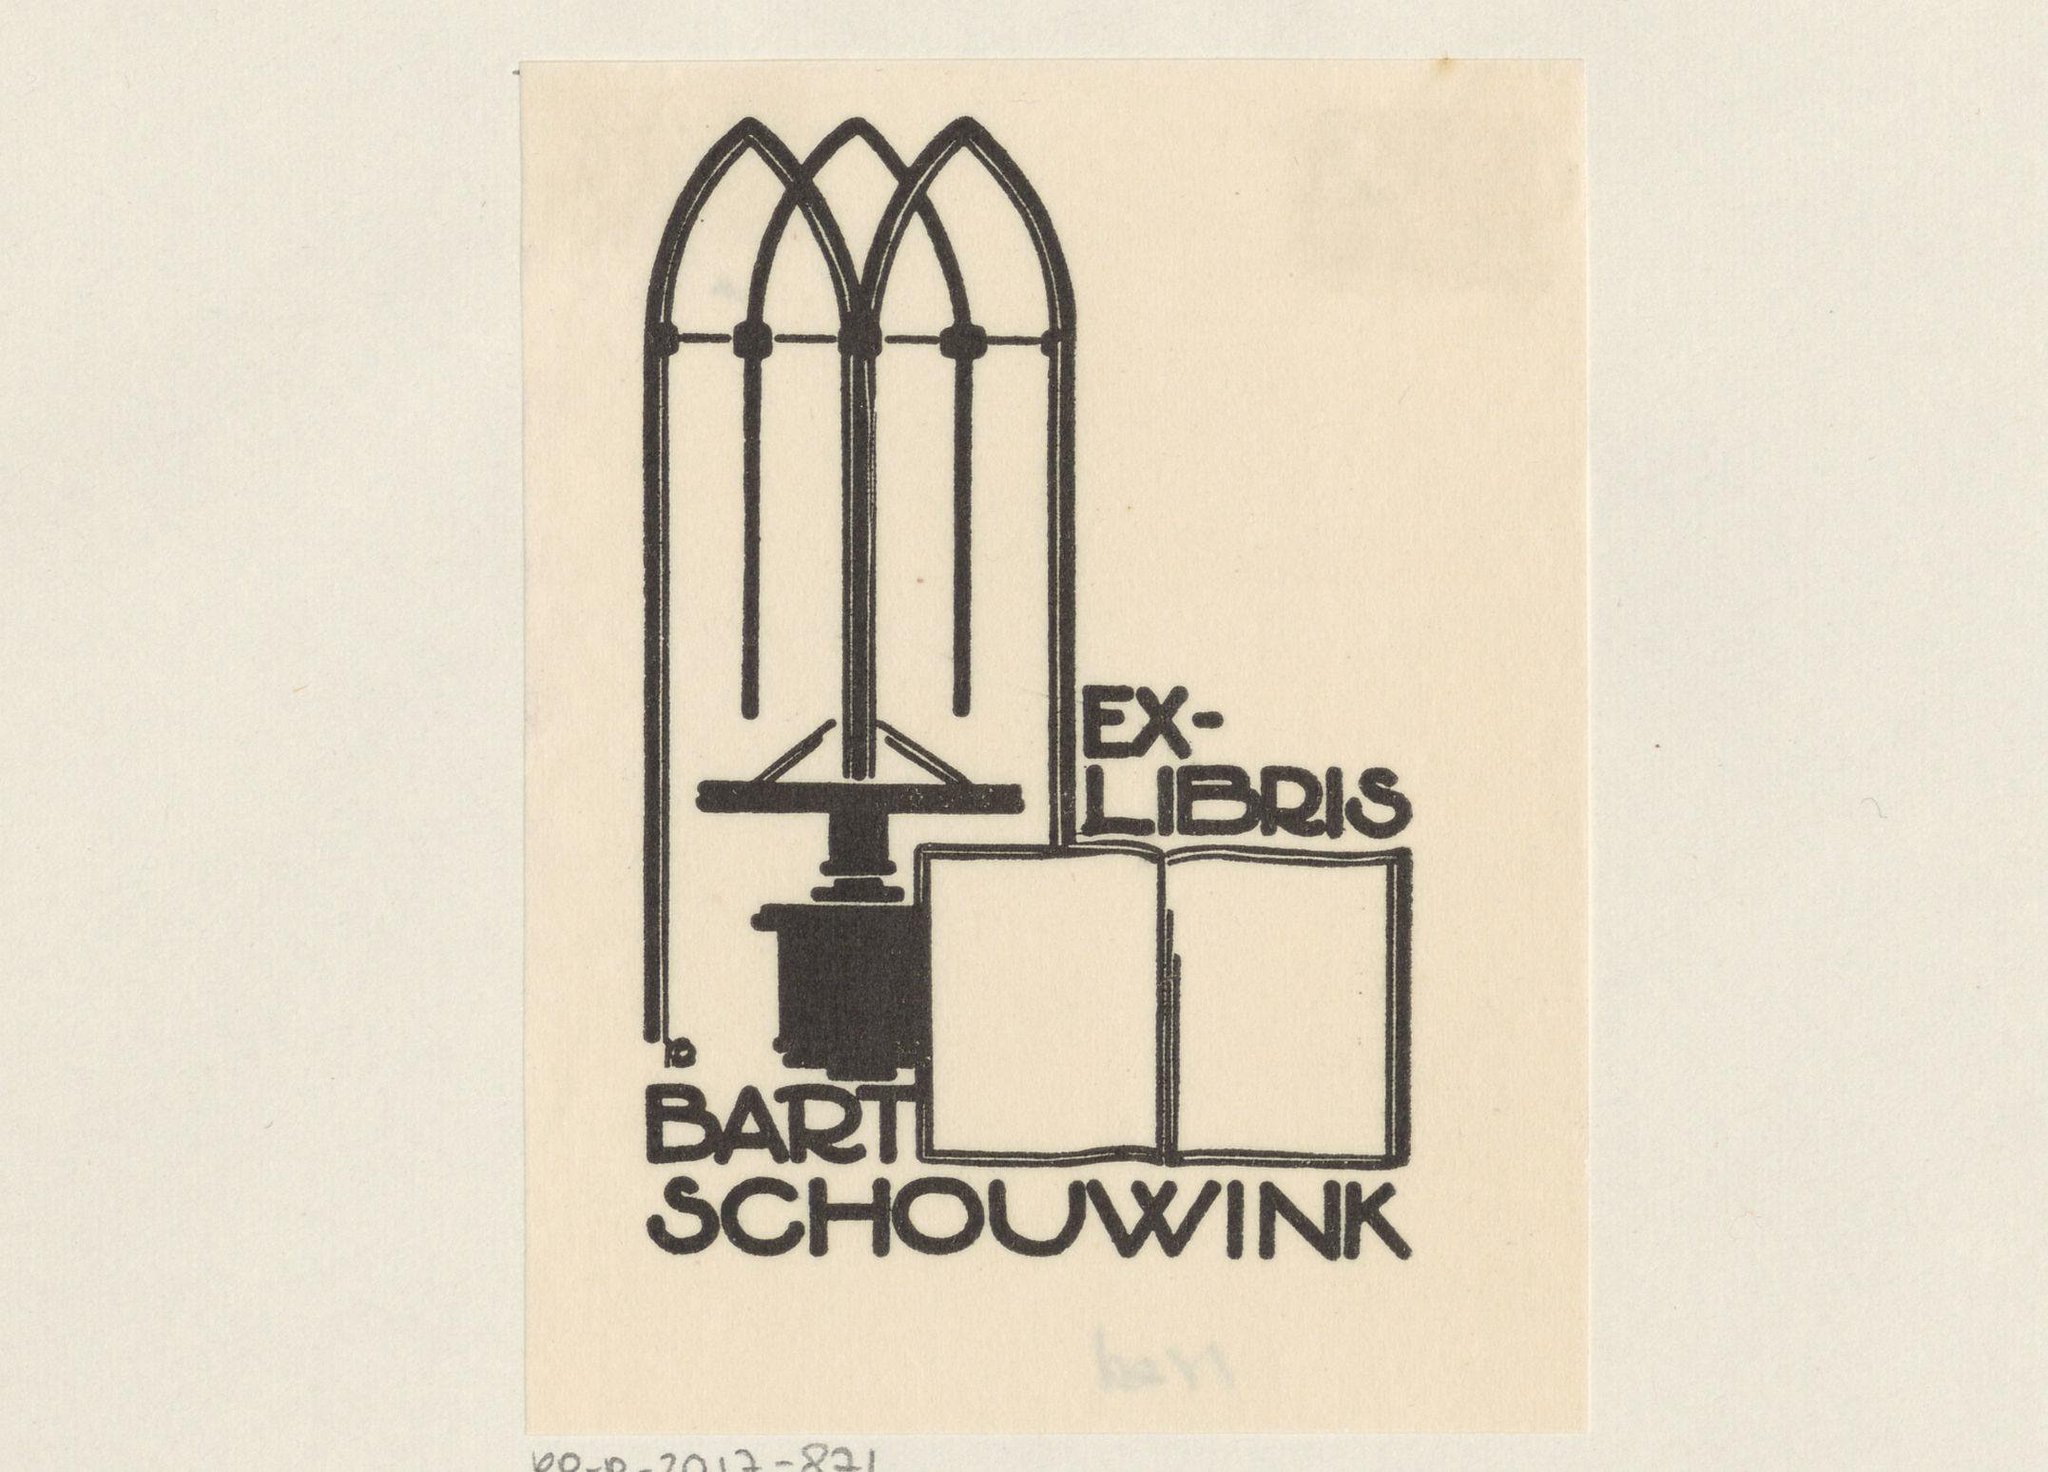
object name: bookplate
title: Ex libris van Bart Schouwink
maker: Anonymous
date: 1930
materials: paper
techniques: printing block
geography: netherlands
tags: church-window, e.g. rose-window, book